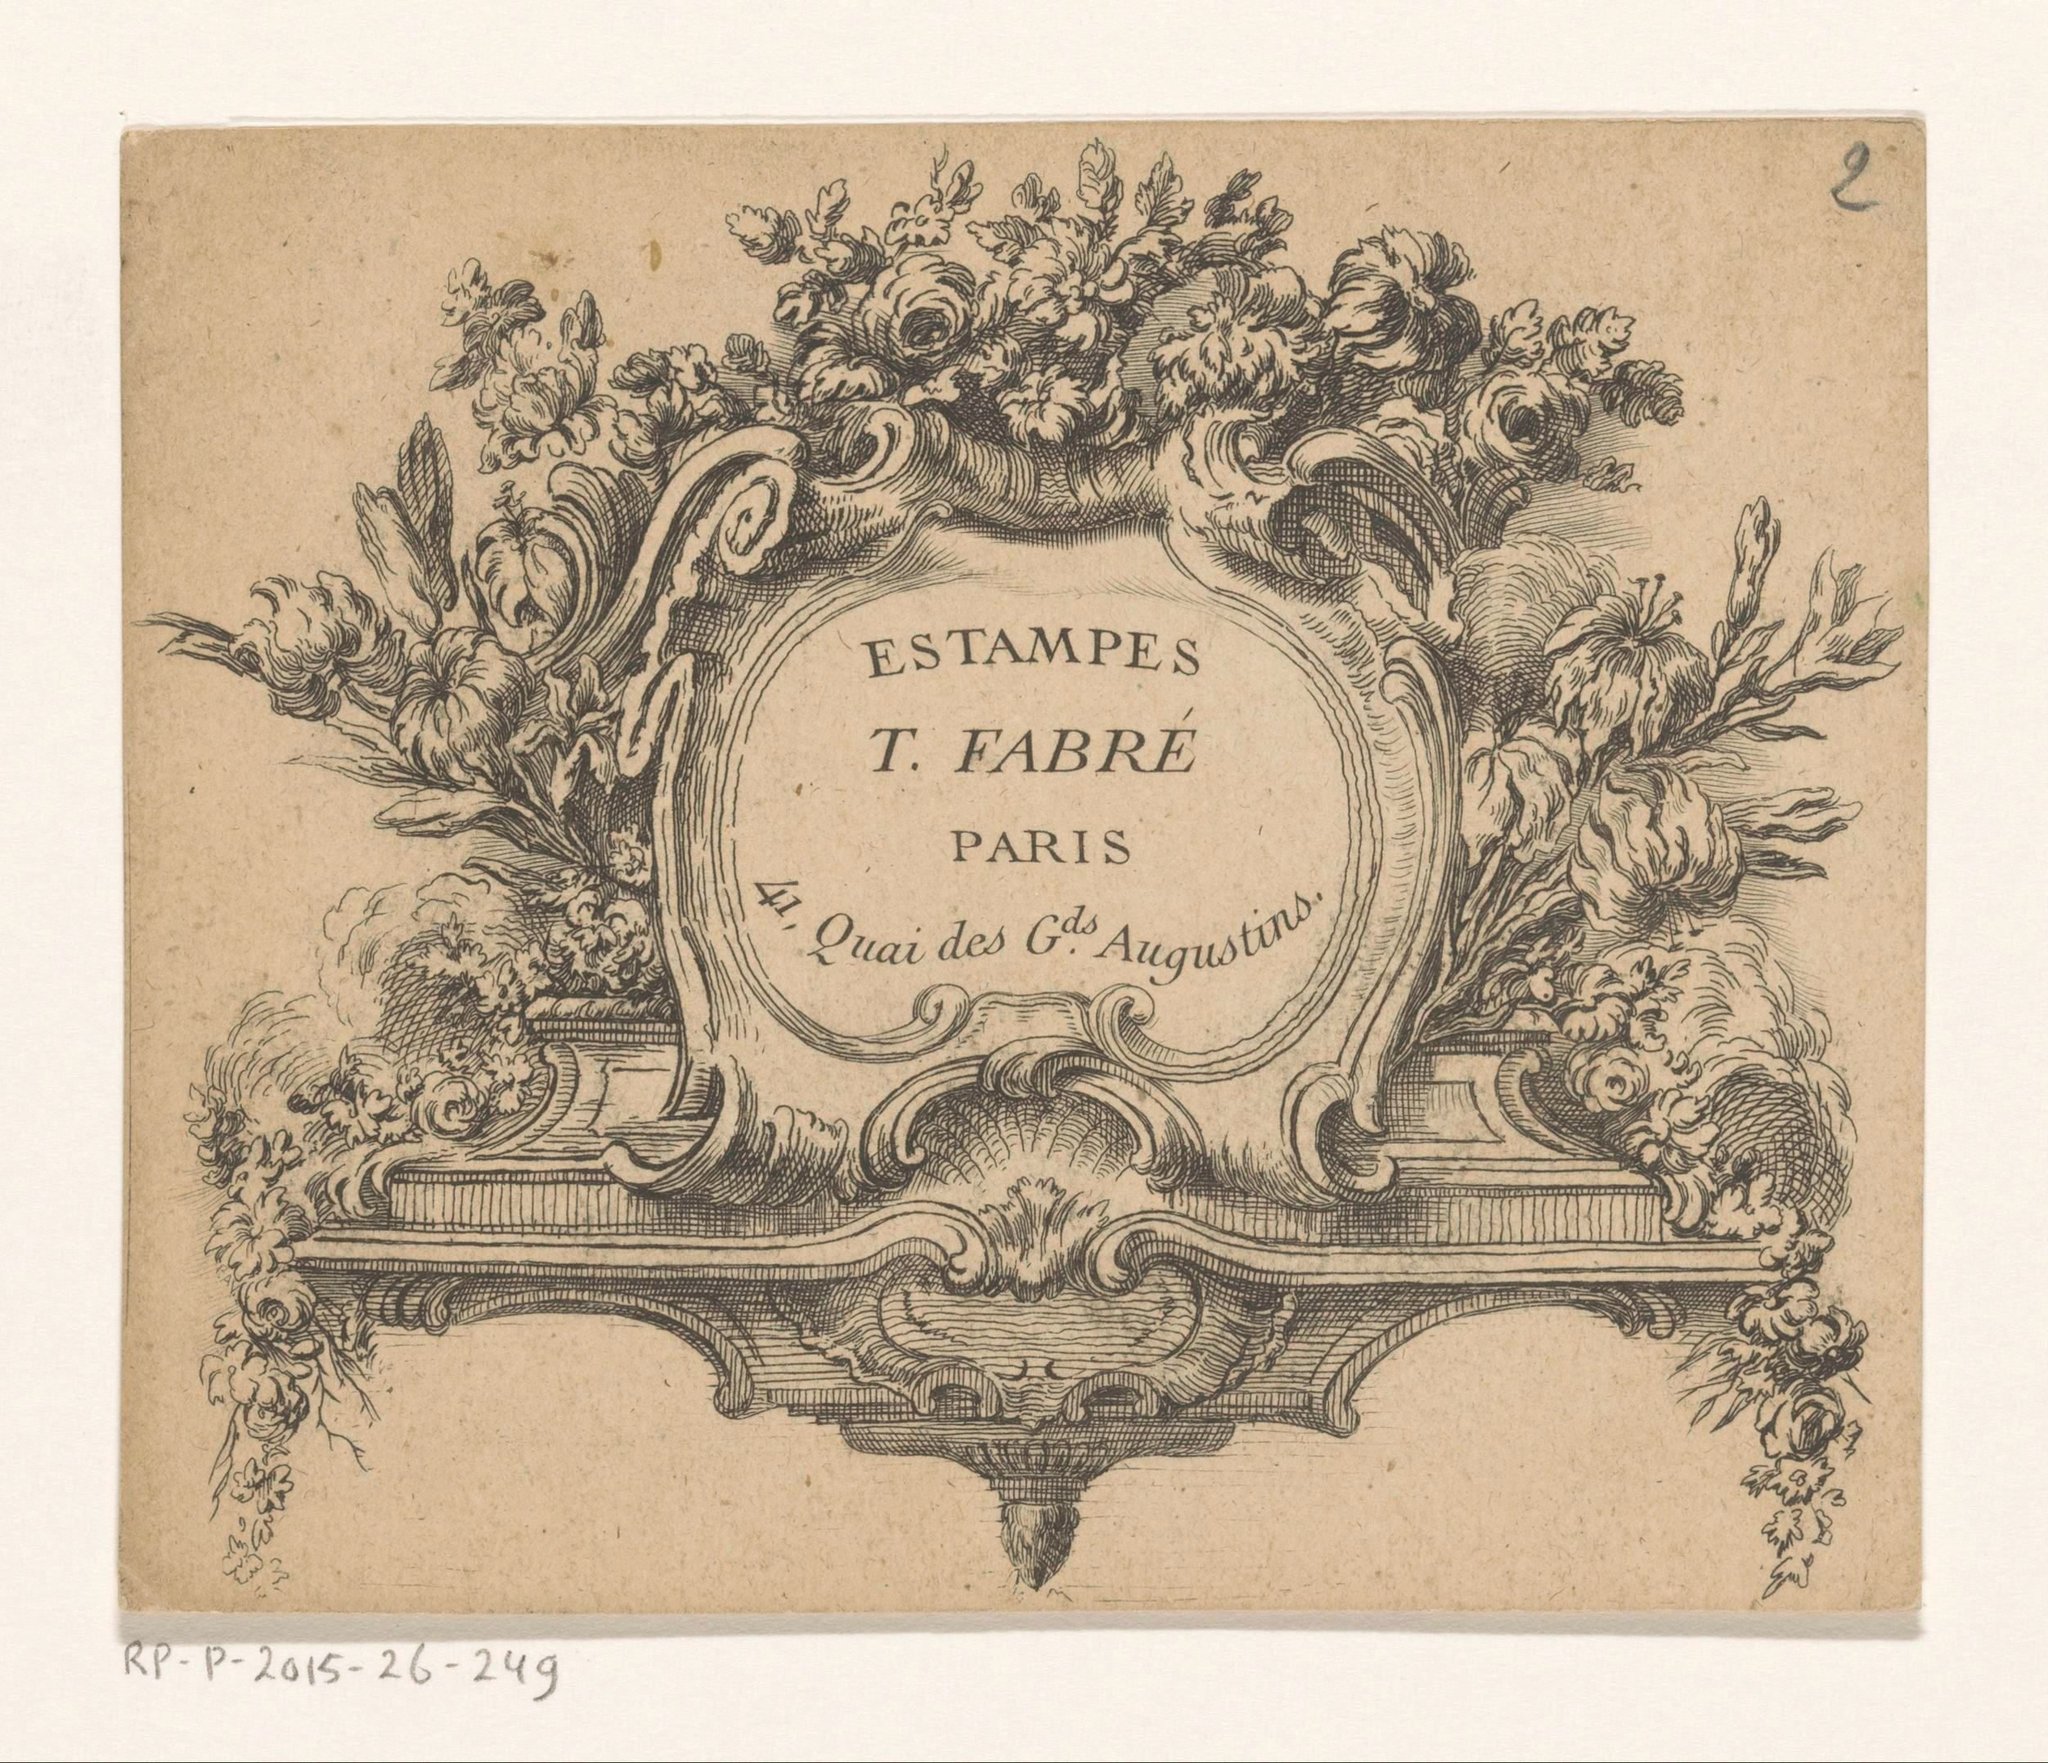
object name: visiting card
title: Visitekaartje van prenthandelaar T. Fabré te Parijs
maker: Anonymous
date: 1800-1900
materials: paper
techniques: engraving, etching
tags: rocaille ornament, bunch of flowers ~ ornament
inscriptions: collector's mark: Lugt 2228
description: Omlijsting met rocaille motieven en bloemen.